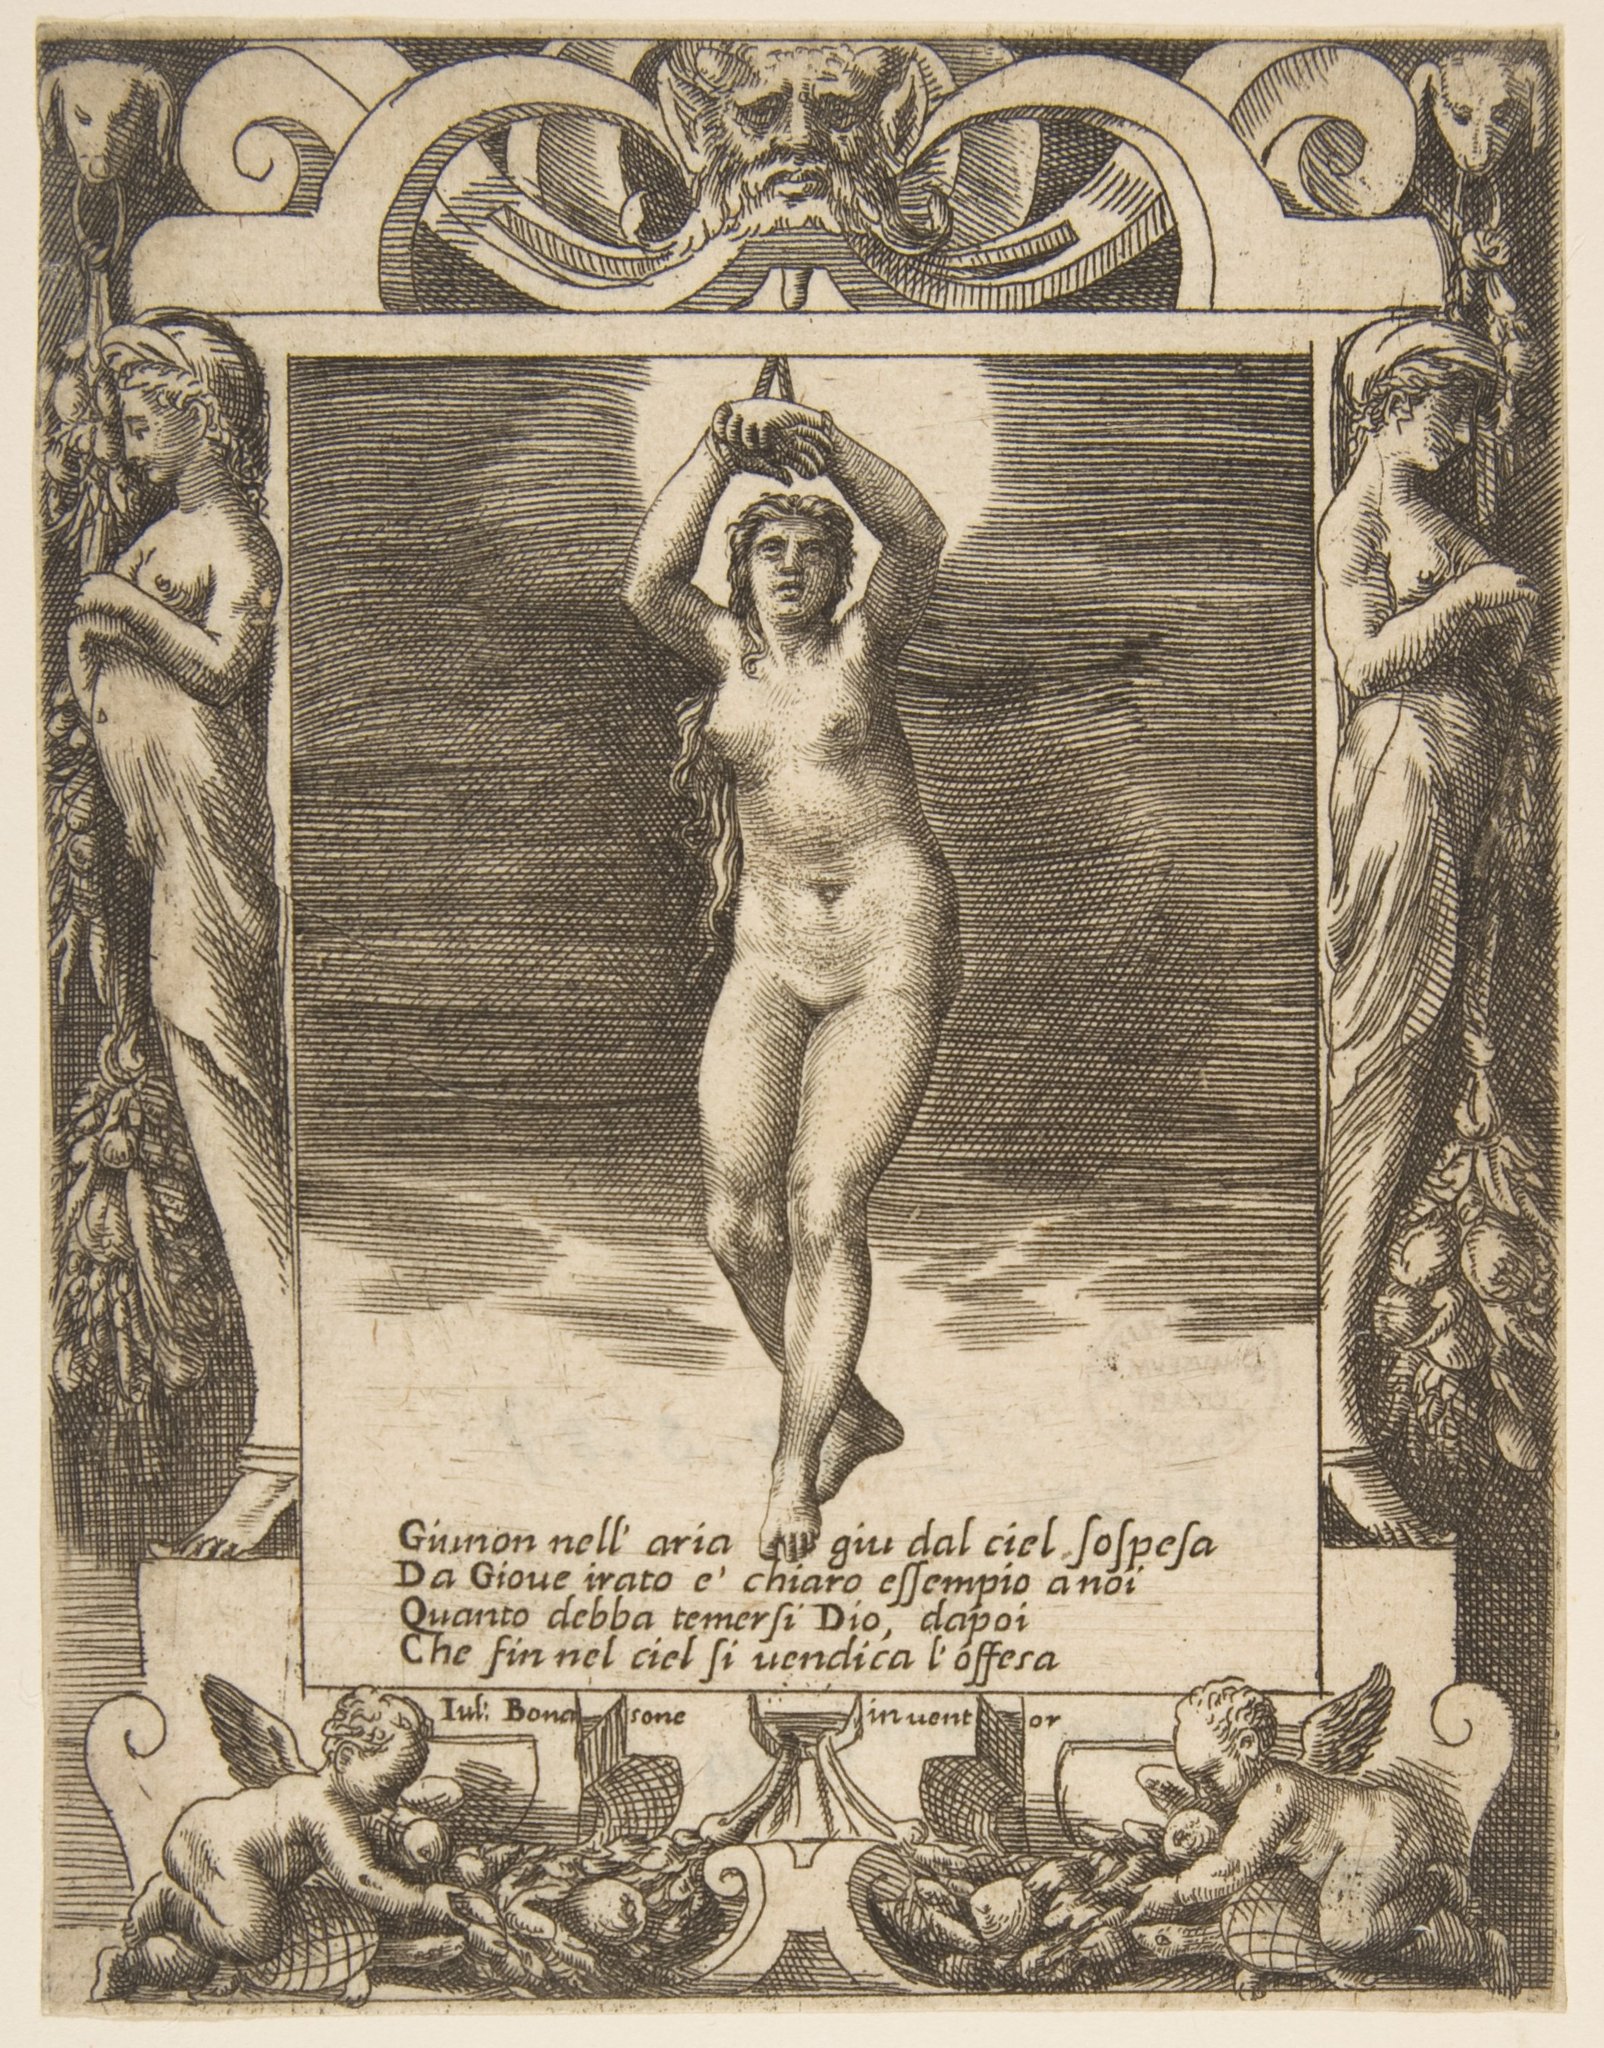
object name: print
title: Juno suspended in the air, set within a frame, from "Loves, Rages and Jealousies of Juno"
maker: giulio bonasone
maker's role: artist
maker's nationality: italian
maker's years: 1510-1576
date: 1531-1576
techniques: engraving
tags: female nudes,juno